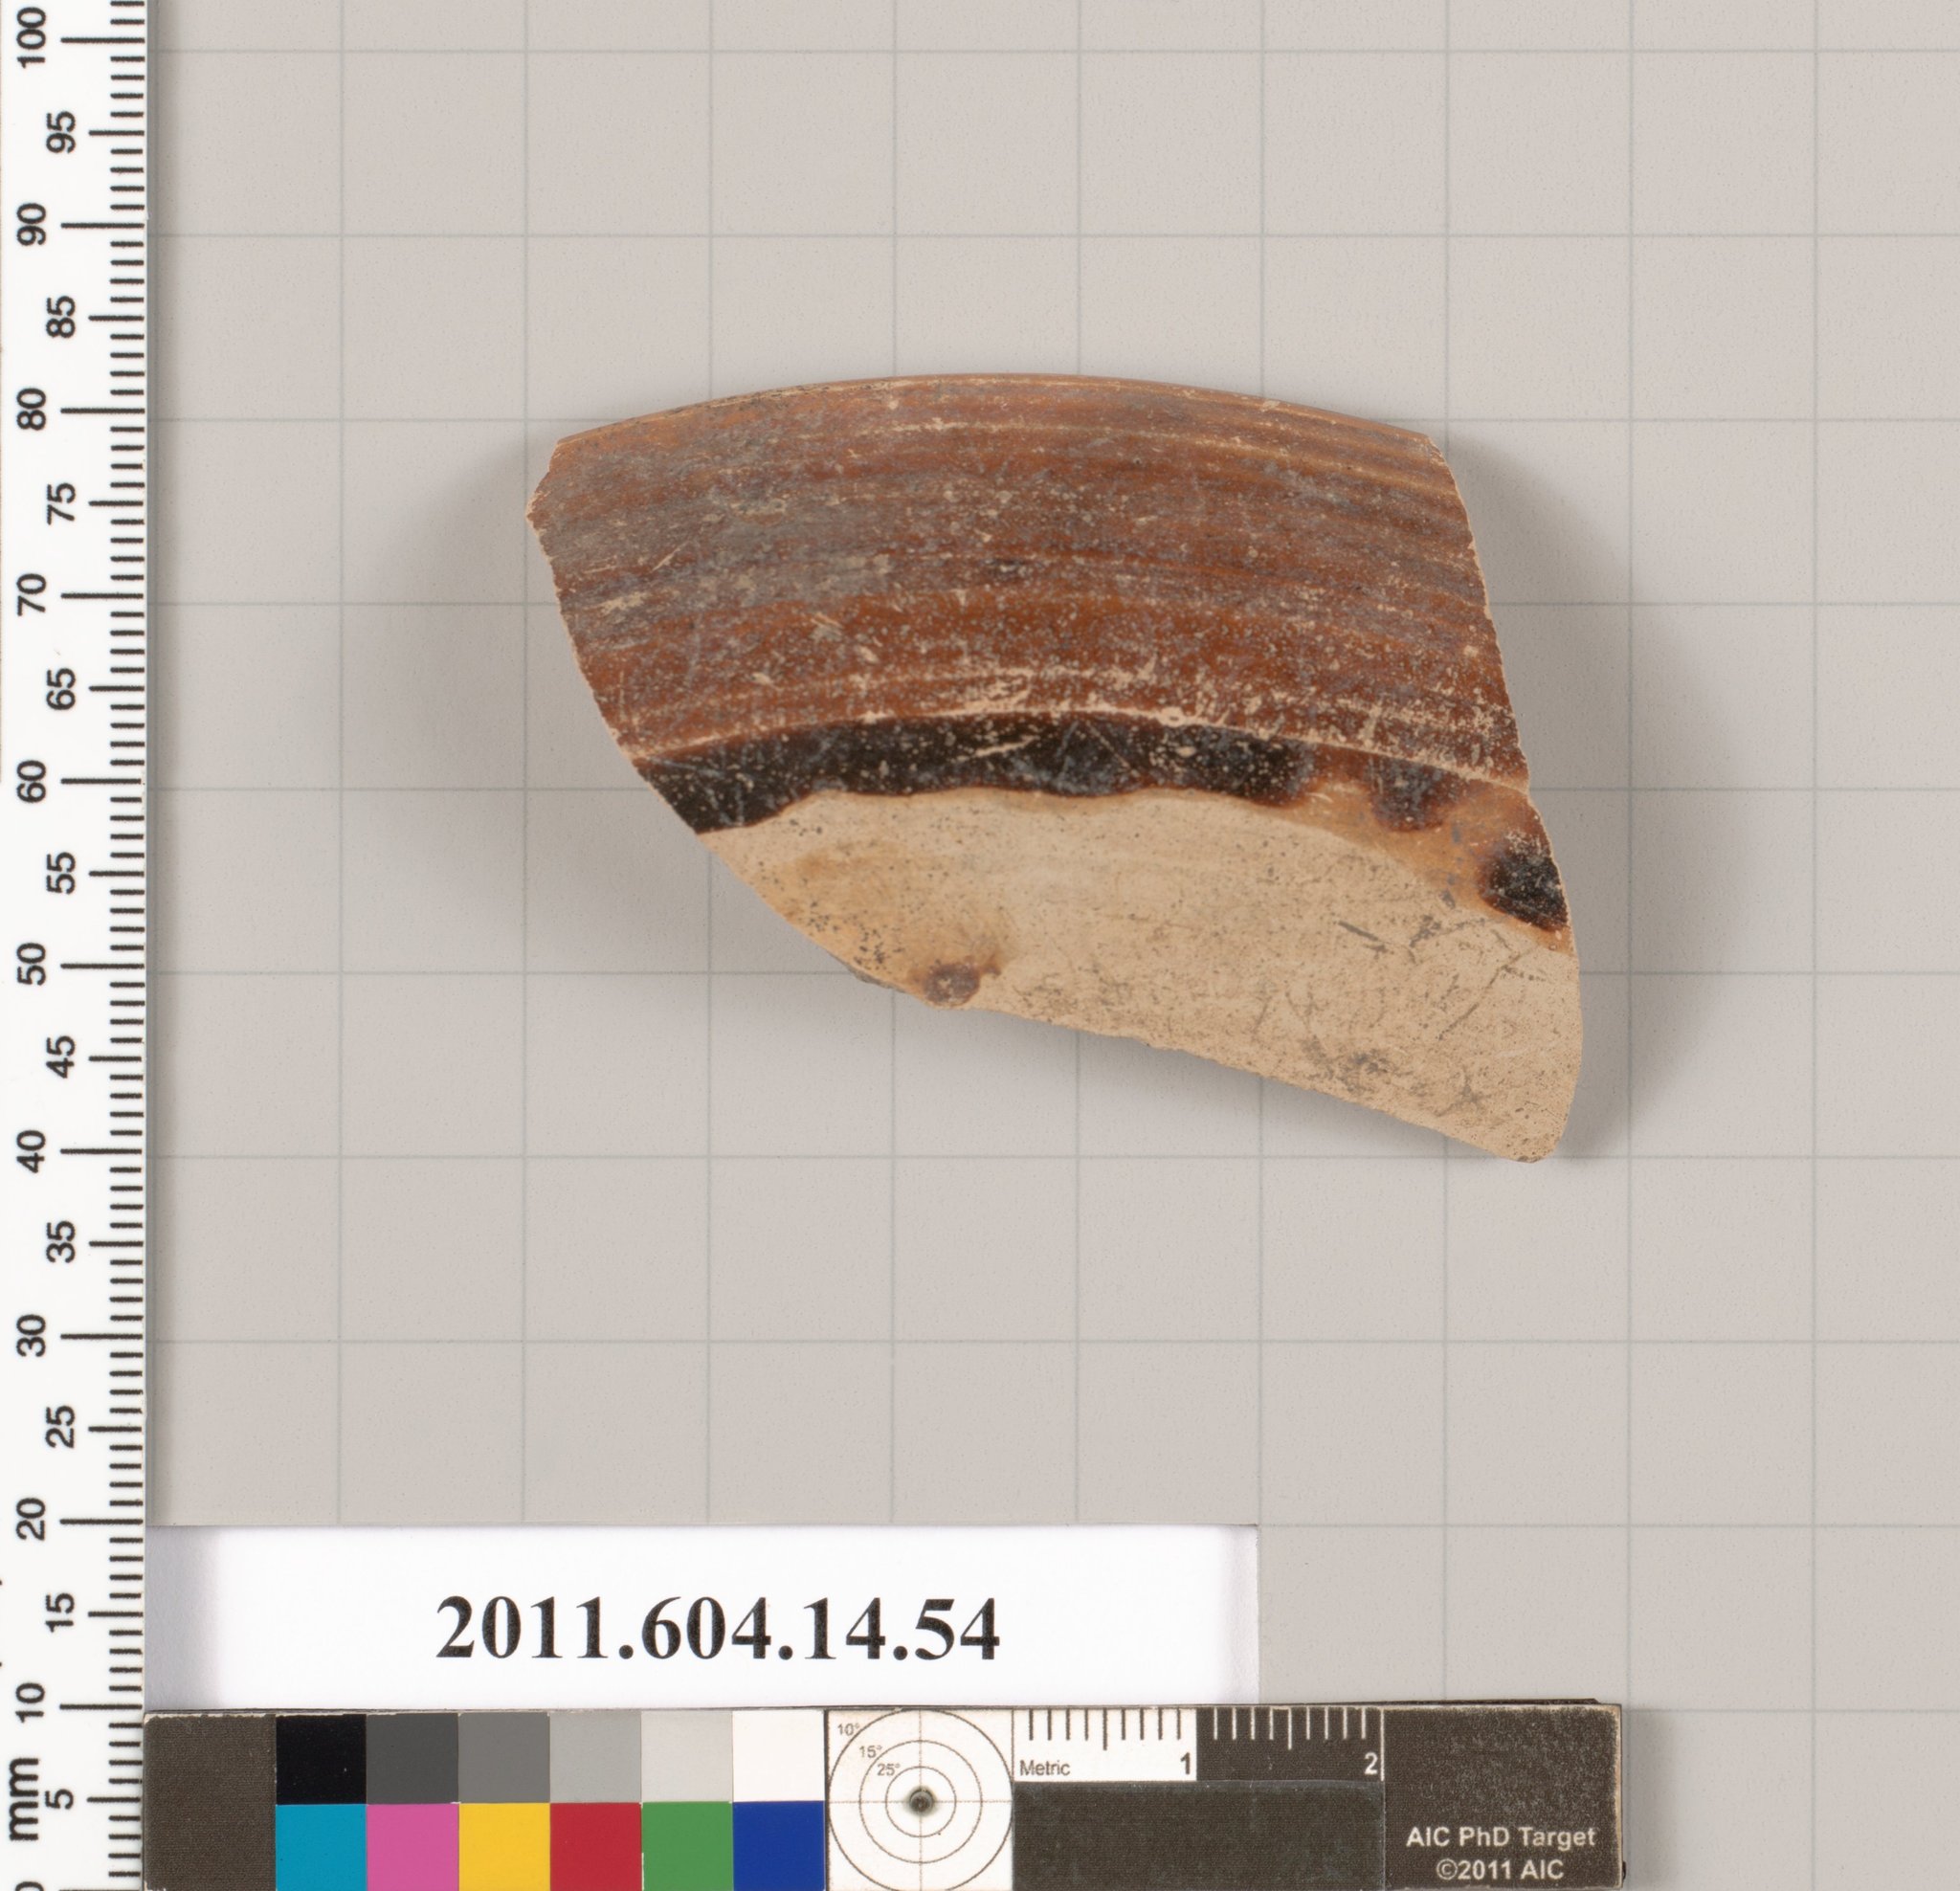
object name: fragment of a bowl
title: Terracotta rim fragment of a bowl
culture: unknown fabric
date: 600-301 BCE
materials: terracotta